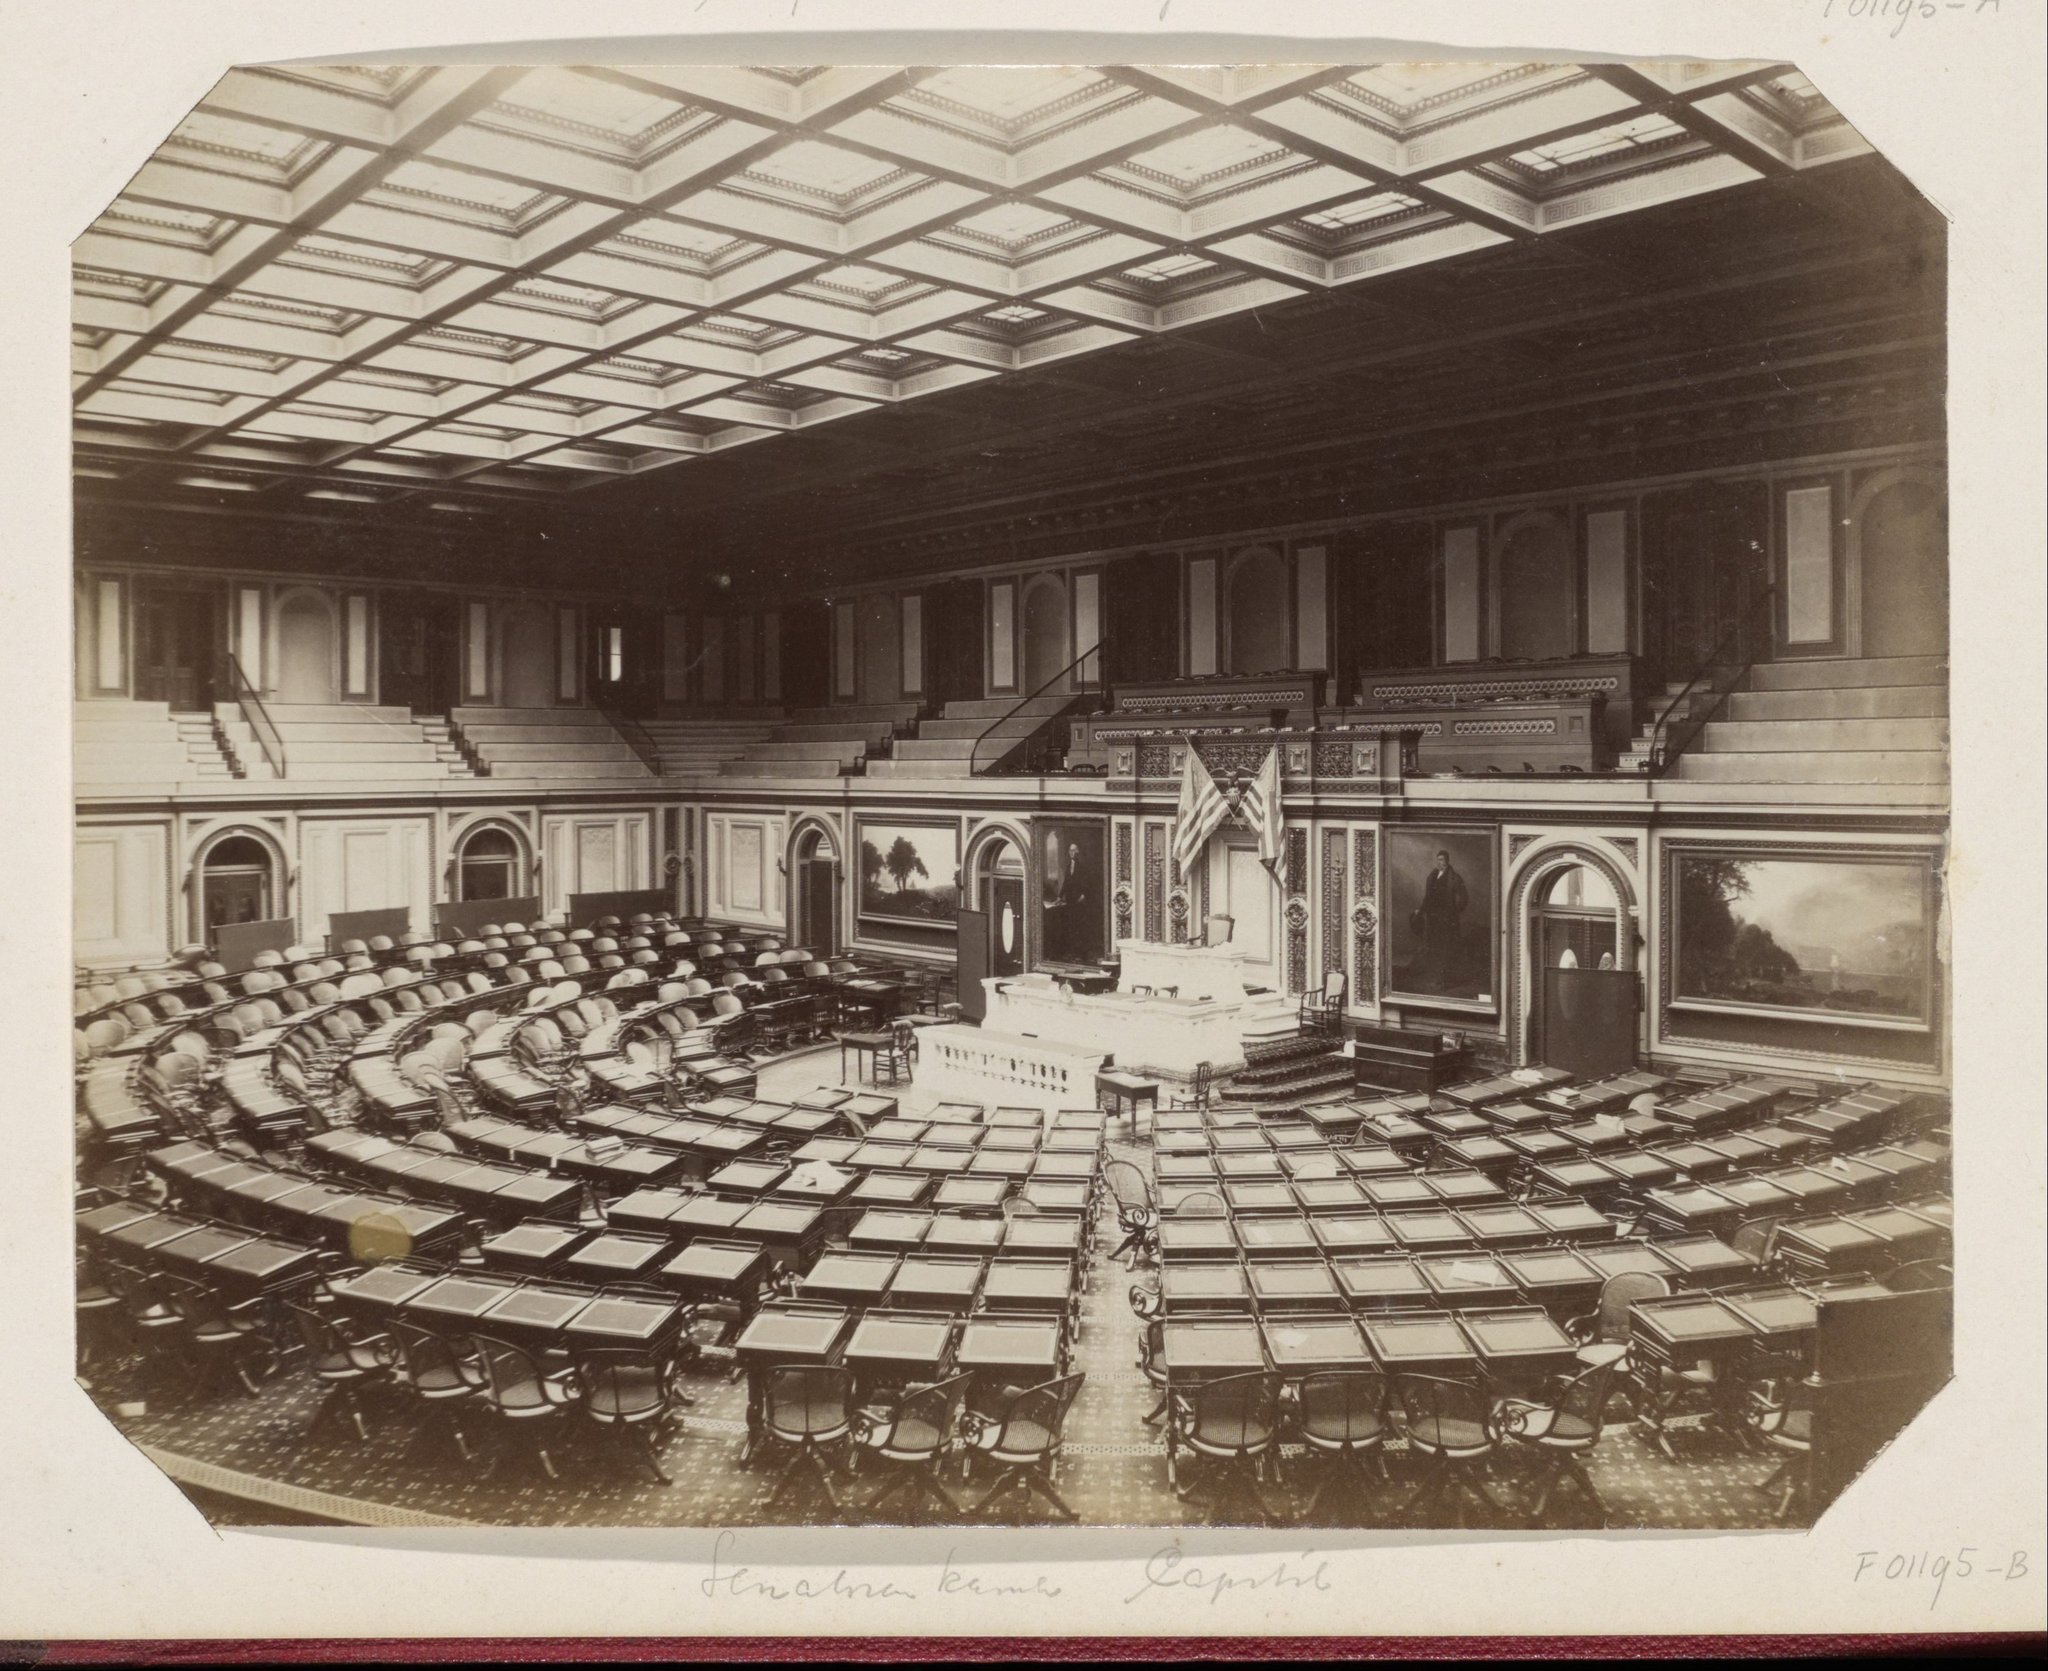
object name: photograph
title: Senaatskamer van het Capitool in Washington D.C.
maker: Anonymous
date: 1860-1900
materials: cardboard, paper, photographic support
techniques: albumen print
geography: washington d.c.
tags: capitool (washington d.c)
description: Onderdeel van Fotoalbum van een reis door de Verenigde Staten, Honolulu, Nederlands-Indië, Aden, Zanzibar en Zuidelijk Afrika.